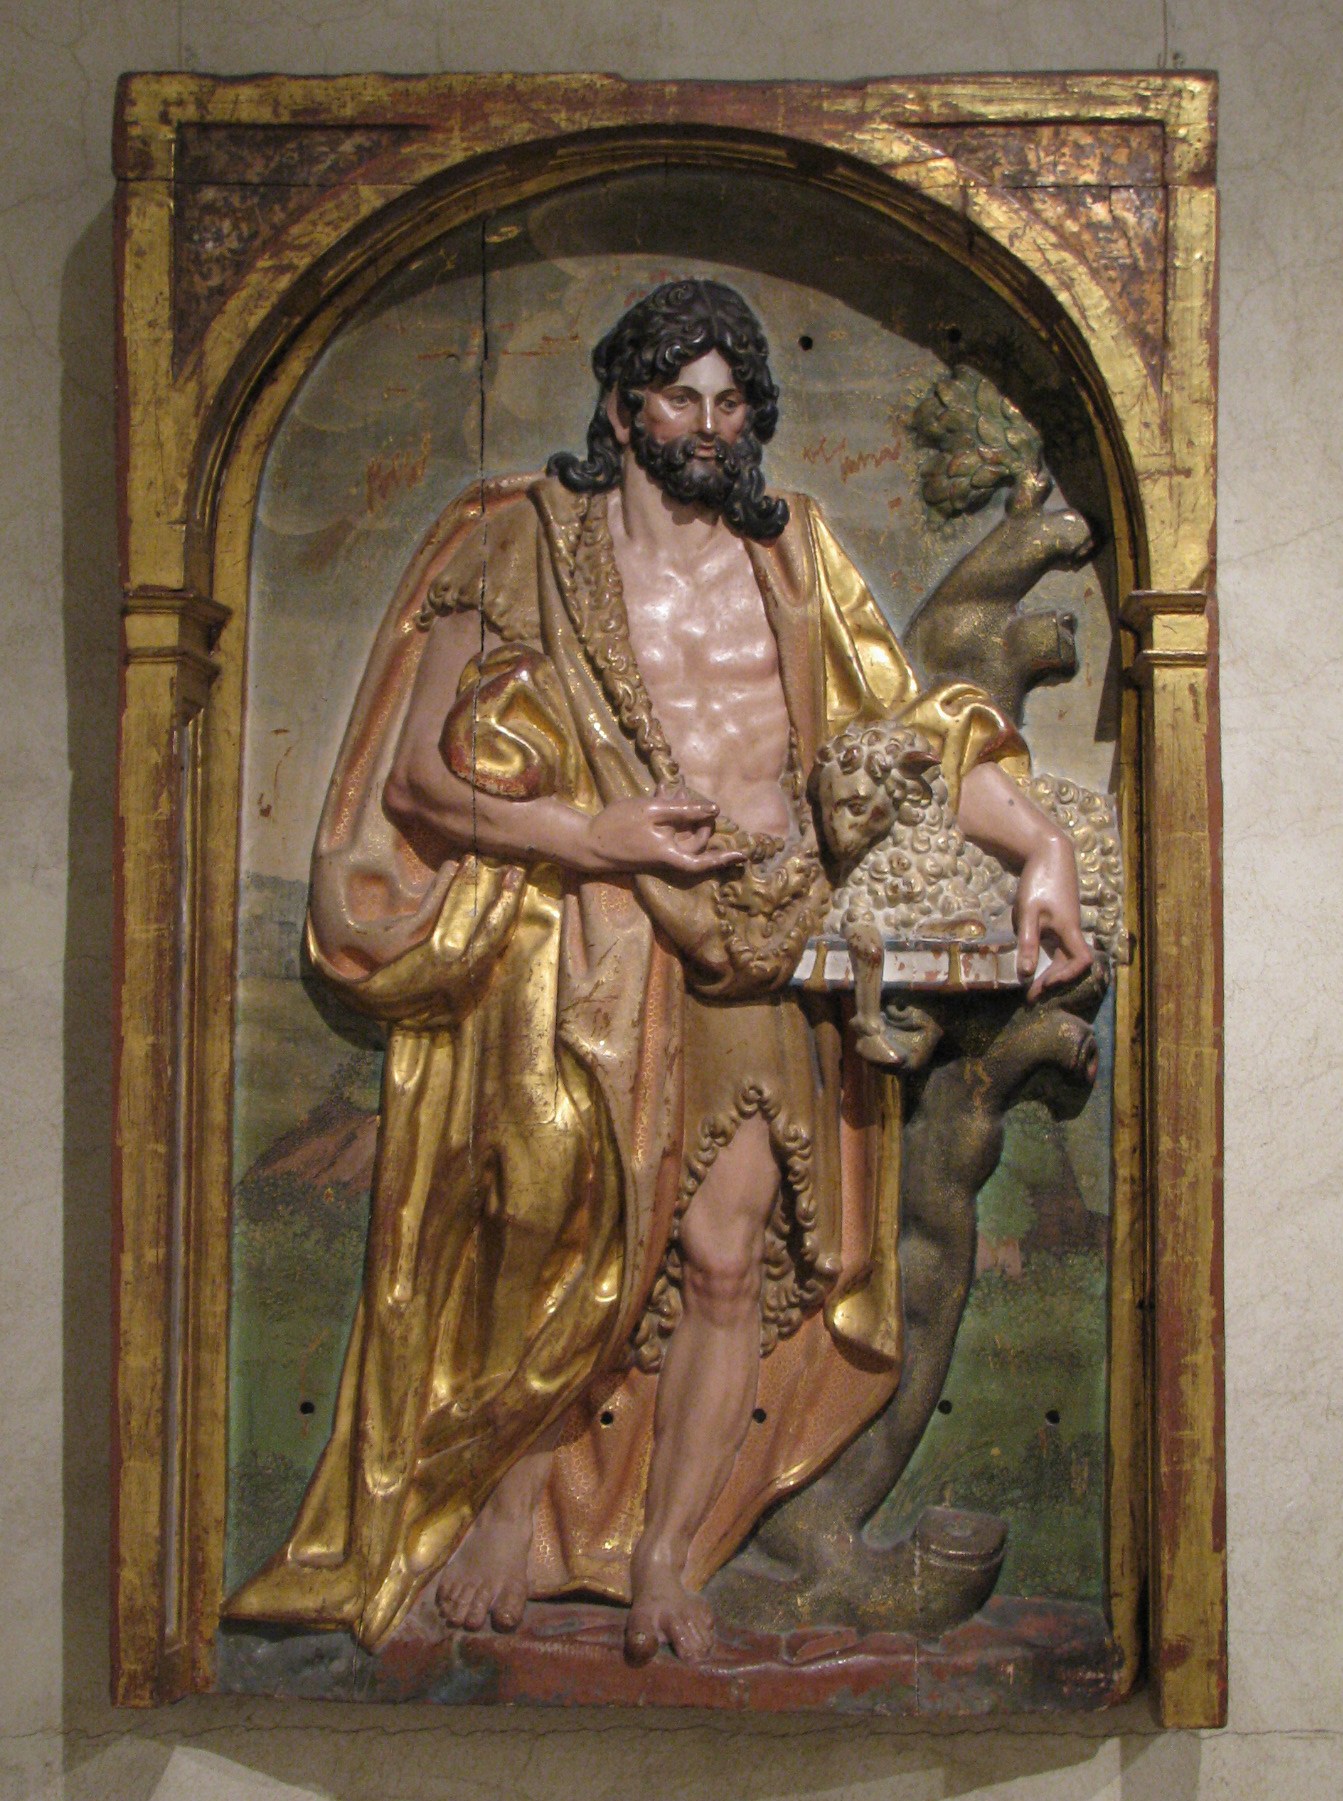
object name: relief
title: Saint John the Baptist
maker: juan de ancheta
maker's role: artist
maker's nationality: spanish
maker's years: 1540-1592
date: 1580-1592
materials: wood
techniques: gilding, polychrome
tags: lambs,saint john the baptist